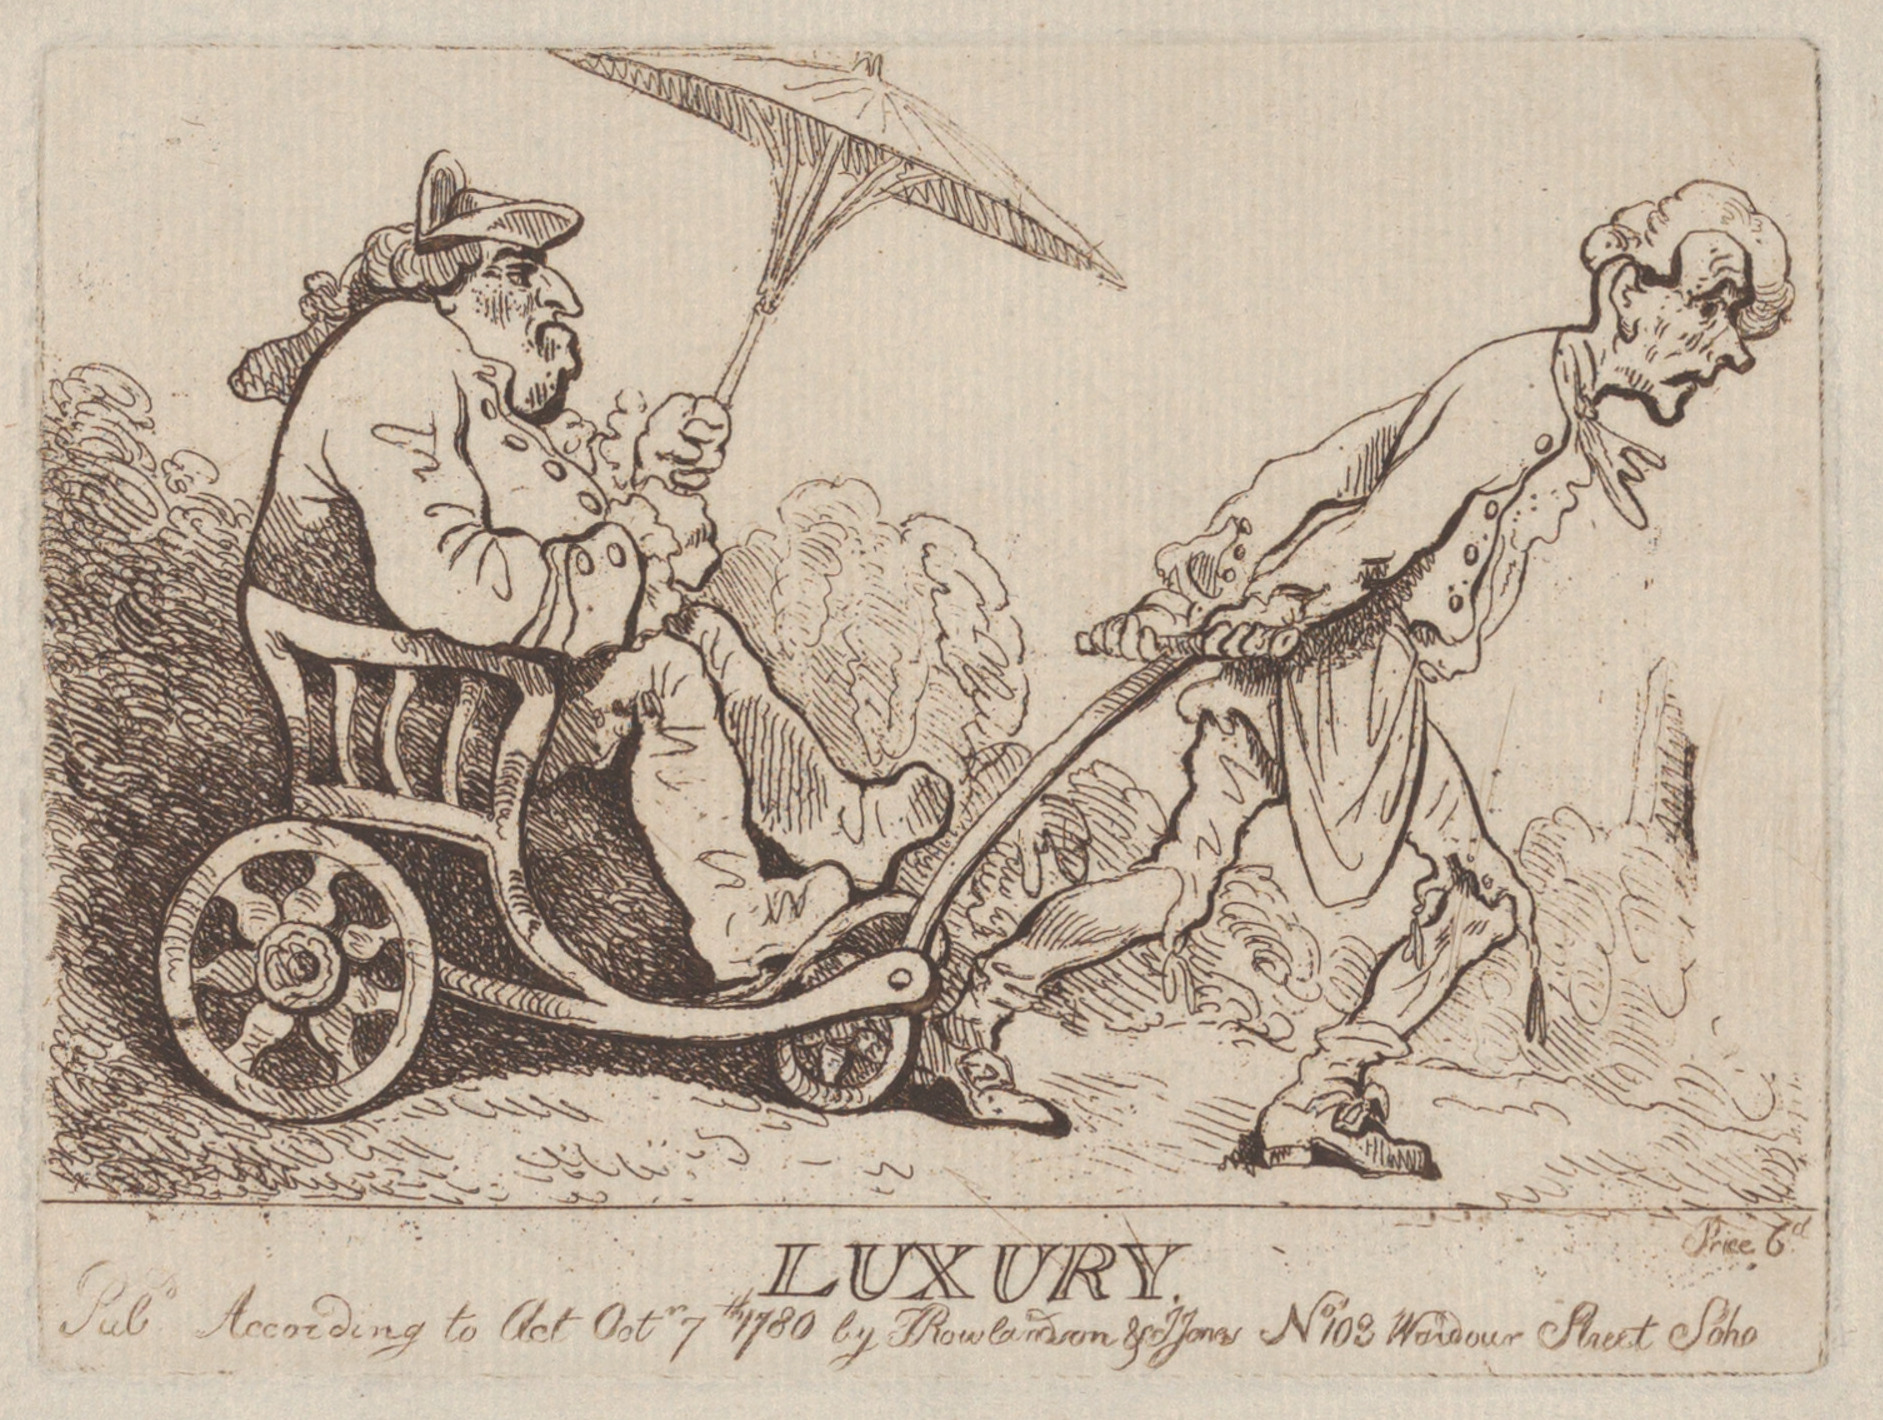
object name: print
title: Luxury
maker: thomas rowlandson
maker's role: artist and engraver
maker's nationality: british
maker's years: 1757-1827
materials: ink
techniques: etching, printing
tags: satire,men